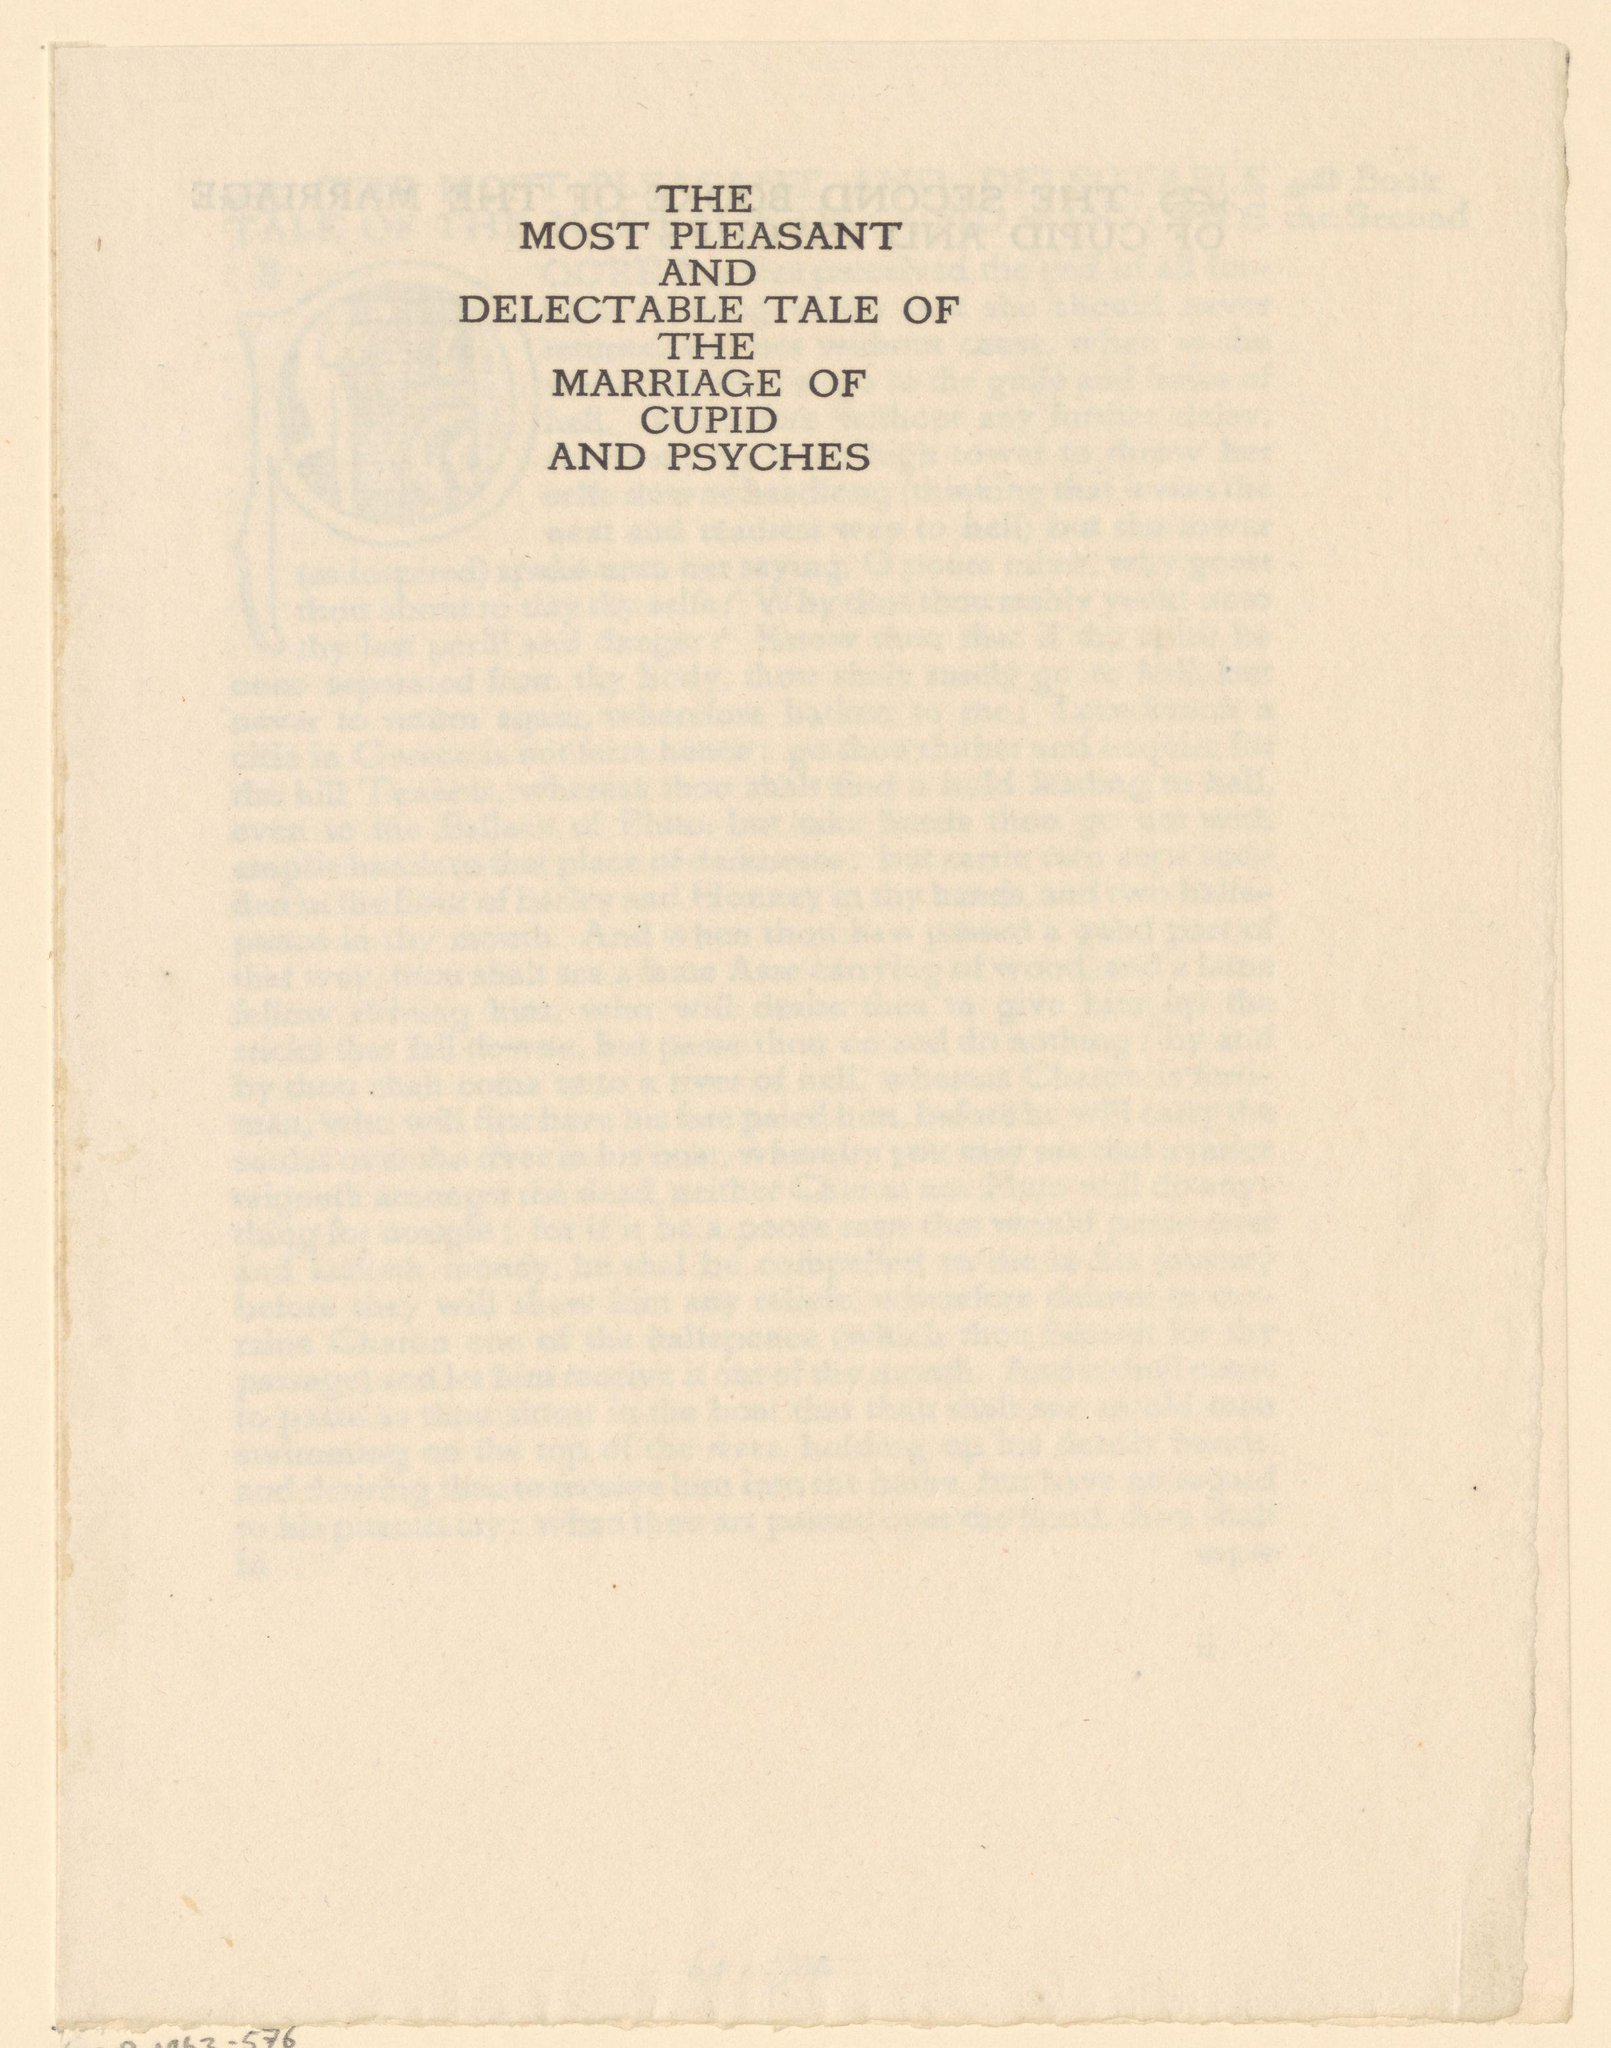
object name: text sheet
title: Tekstblad met initialen met vrouw en draak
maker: charles ricketts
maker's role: print maker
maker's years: 1866-1931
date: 1896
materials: paper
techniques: letterpress printing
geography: london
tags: adult woman, fancy letters, dragon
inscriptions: collector's mark: Lugt 2228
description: Prent uit: The Dial 4 (1896). Bijlage bij het tijdschrift.